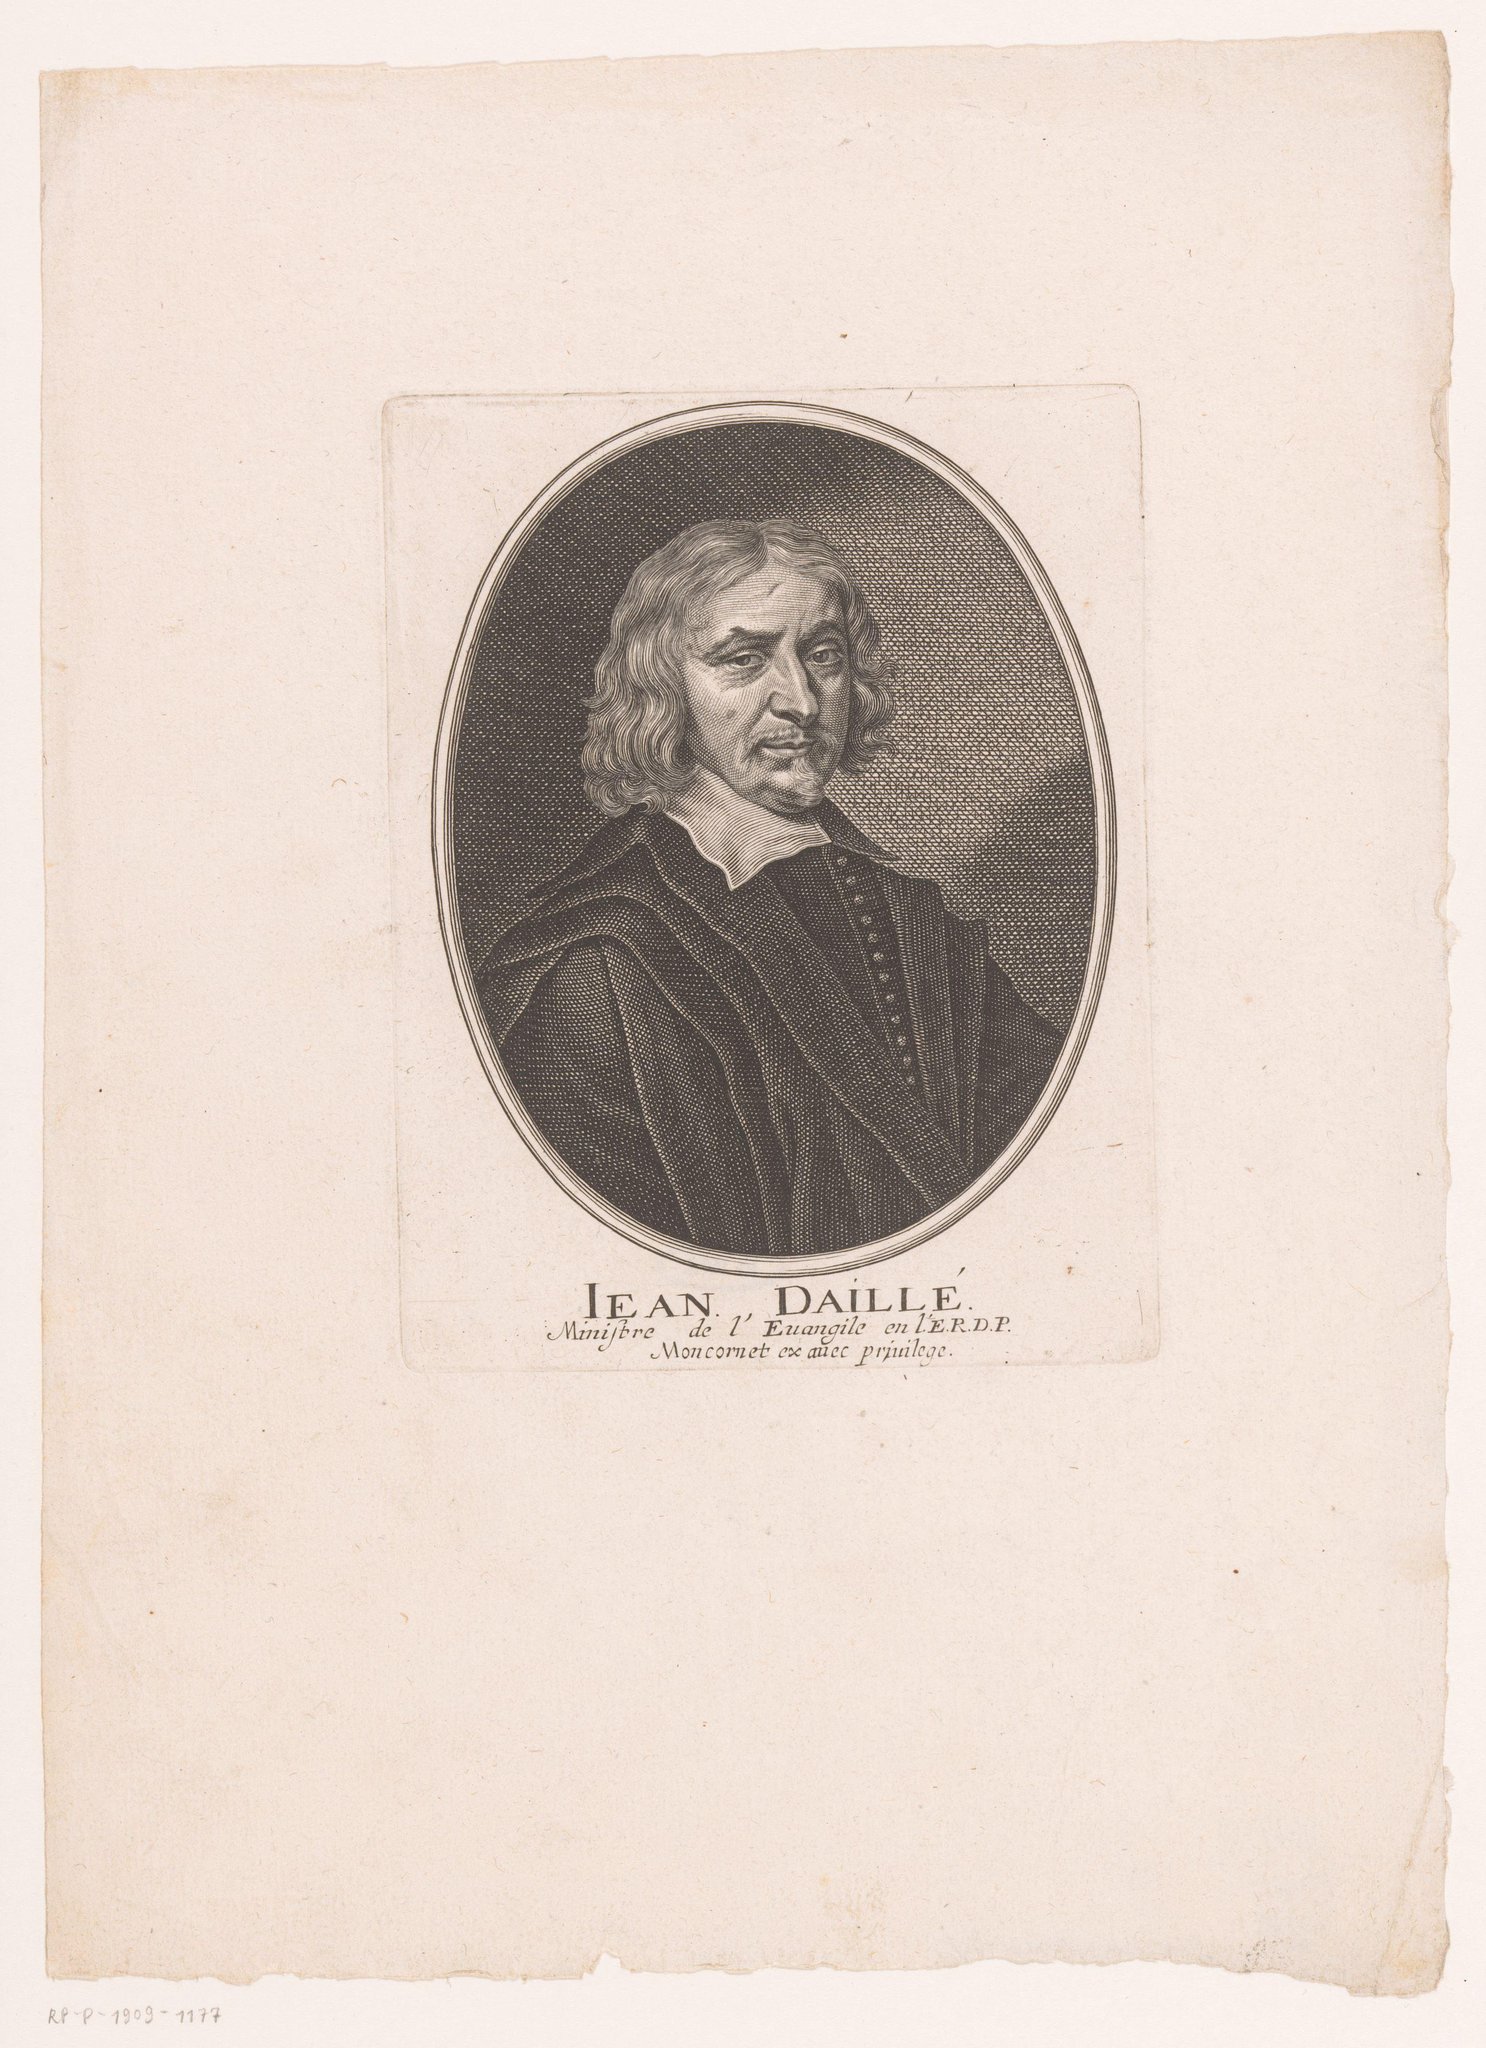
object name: print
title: Portret van Jean Daillé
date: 1659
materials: paper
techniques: engraving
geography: paris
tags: historical persons, politician, e.g. party leader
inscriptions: collector's mark: Lugt 2228